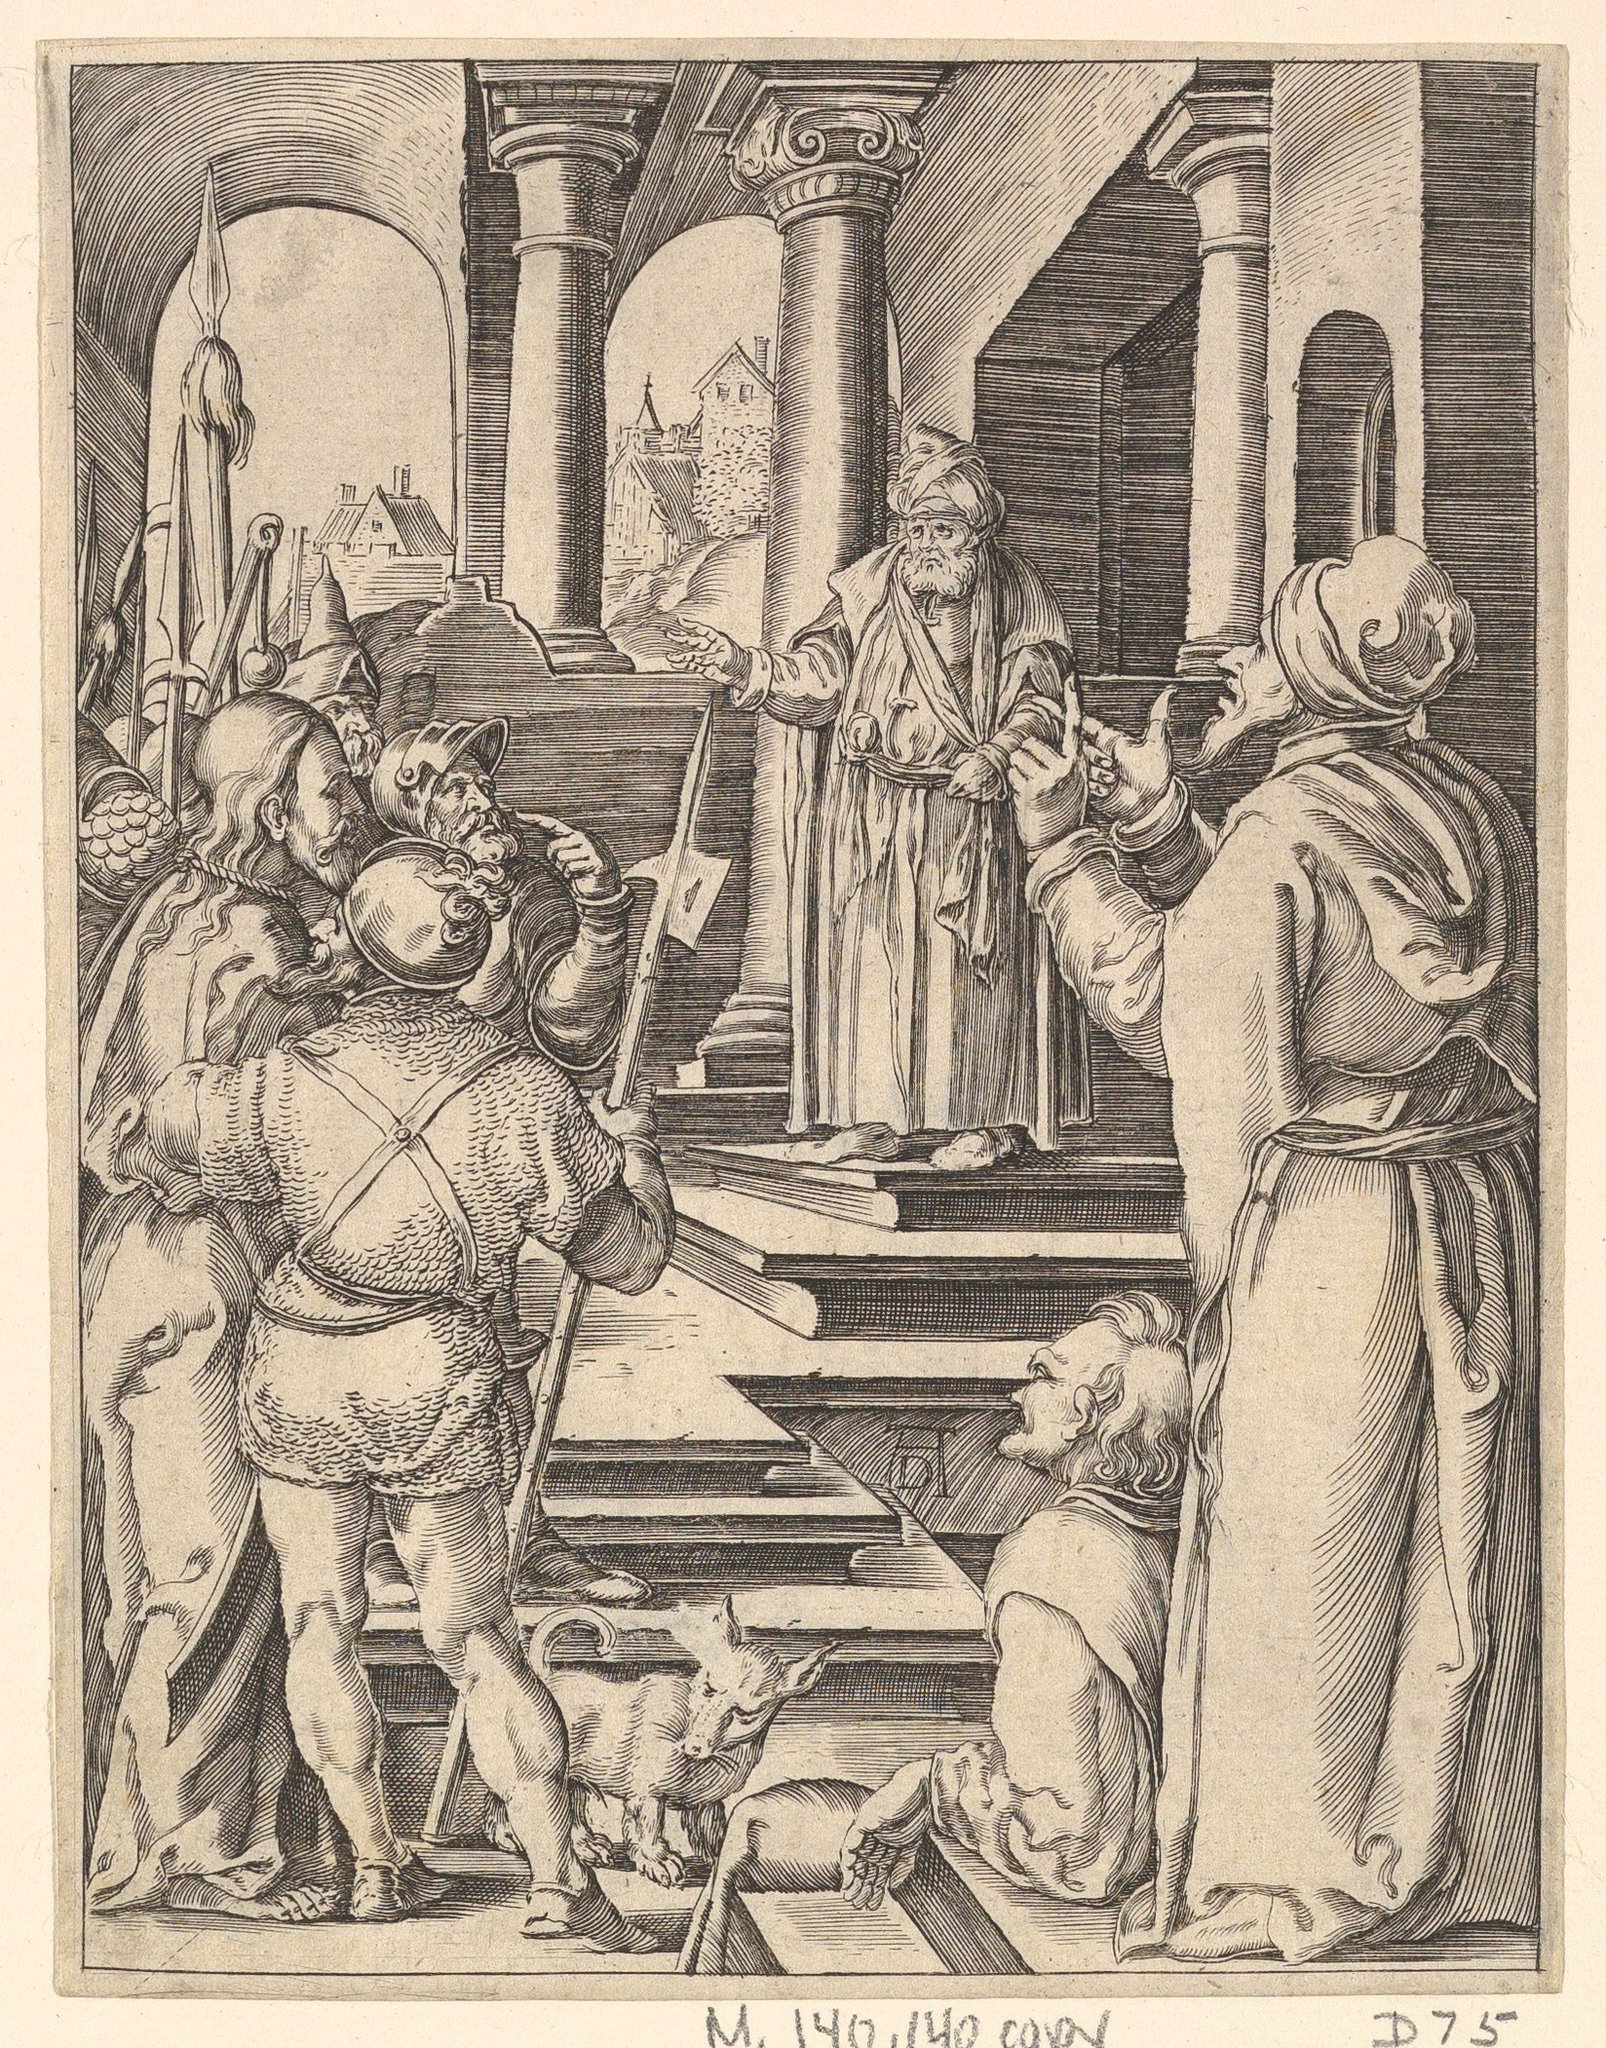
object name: print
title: Engraved copies of The Little Passion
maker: albrecht dürer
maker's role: artist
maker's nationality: german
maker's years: 1471-1528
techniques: engraving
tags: animals,soldiers,weapons,men